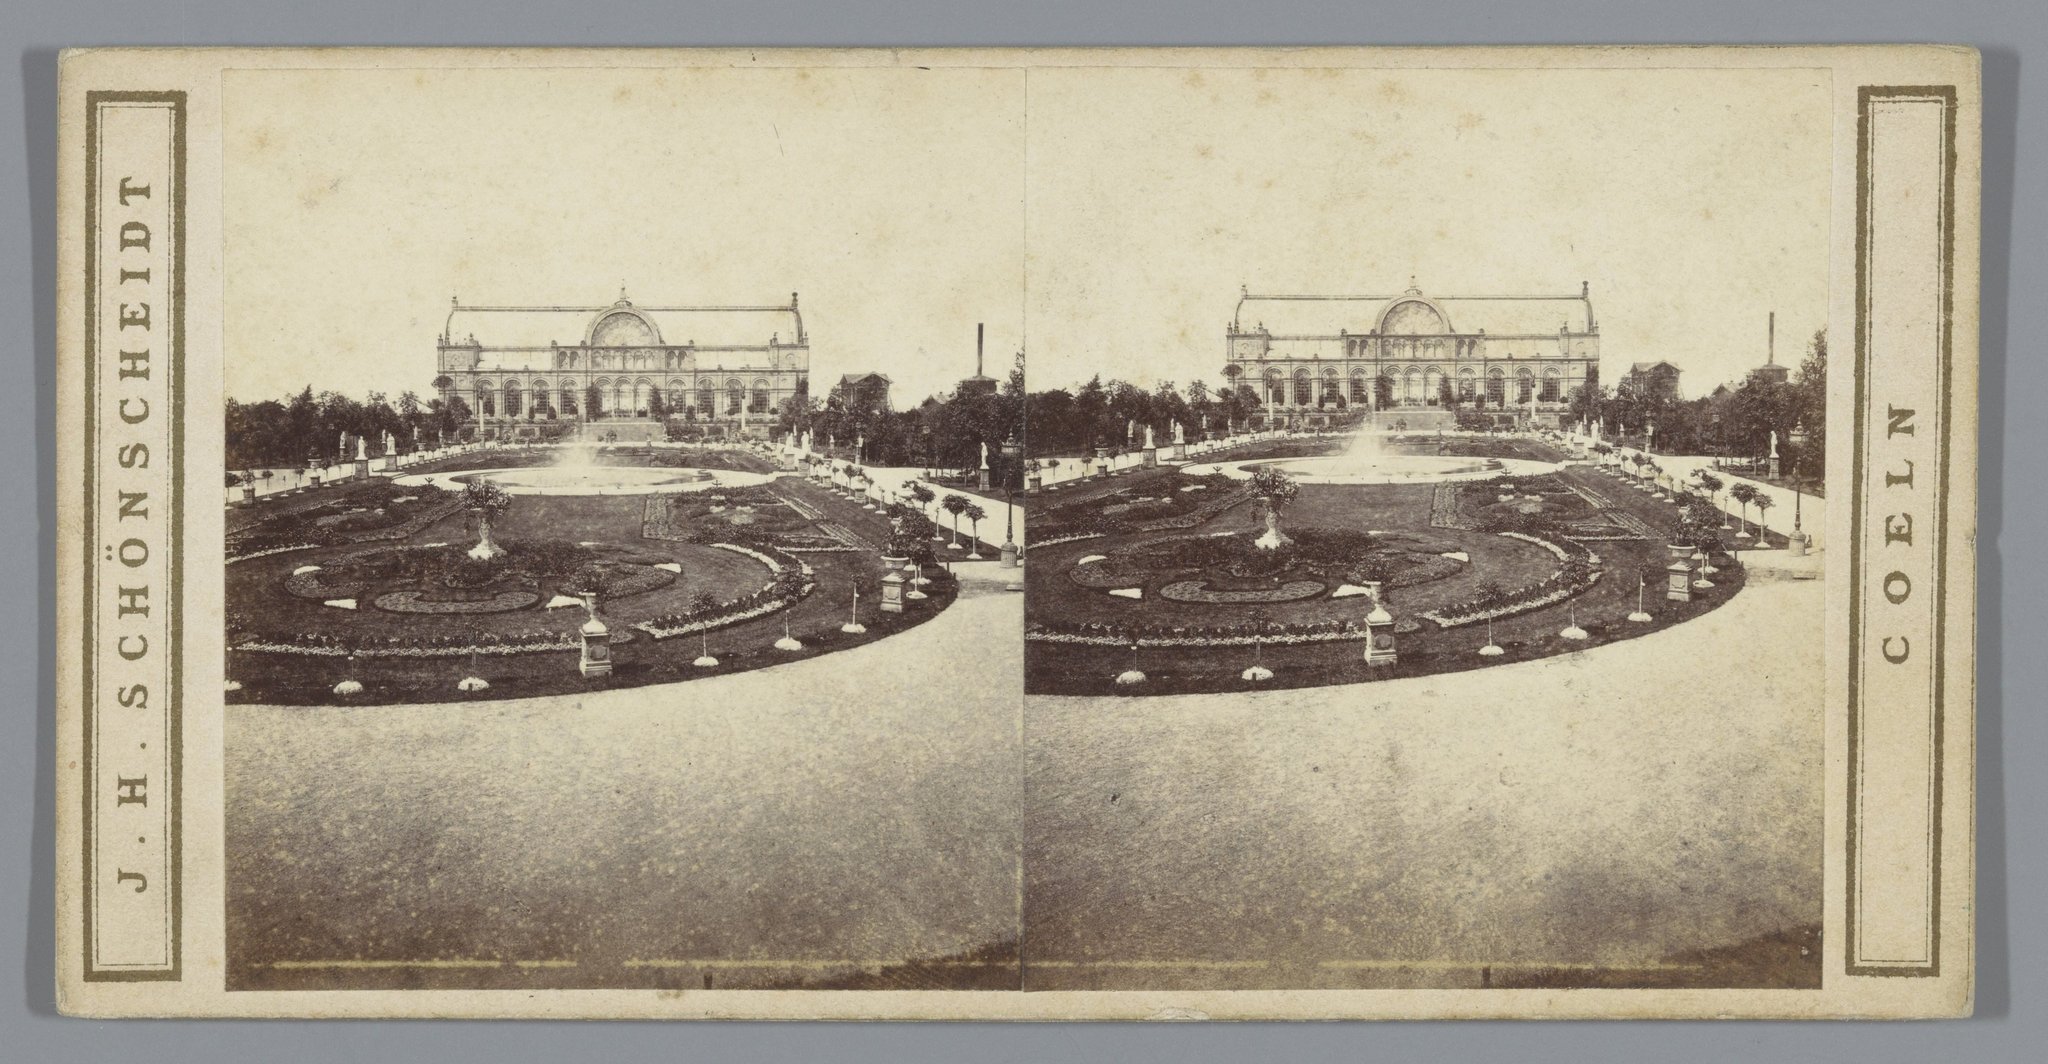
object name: stereograph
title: Coeln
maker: johann heinrich schönscheidt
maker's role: fotograaf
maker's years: 1835-1903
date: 1863-1880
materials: cardboard, photographic support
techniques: albumen print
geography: cologne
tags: botanic garden, 'hortus botanicus'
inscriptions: number: ‘No 52’, inscription: ‘Keulen Plantentuin’